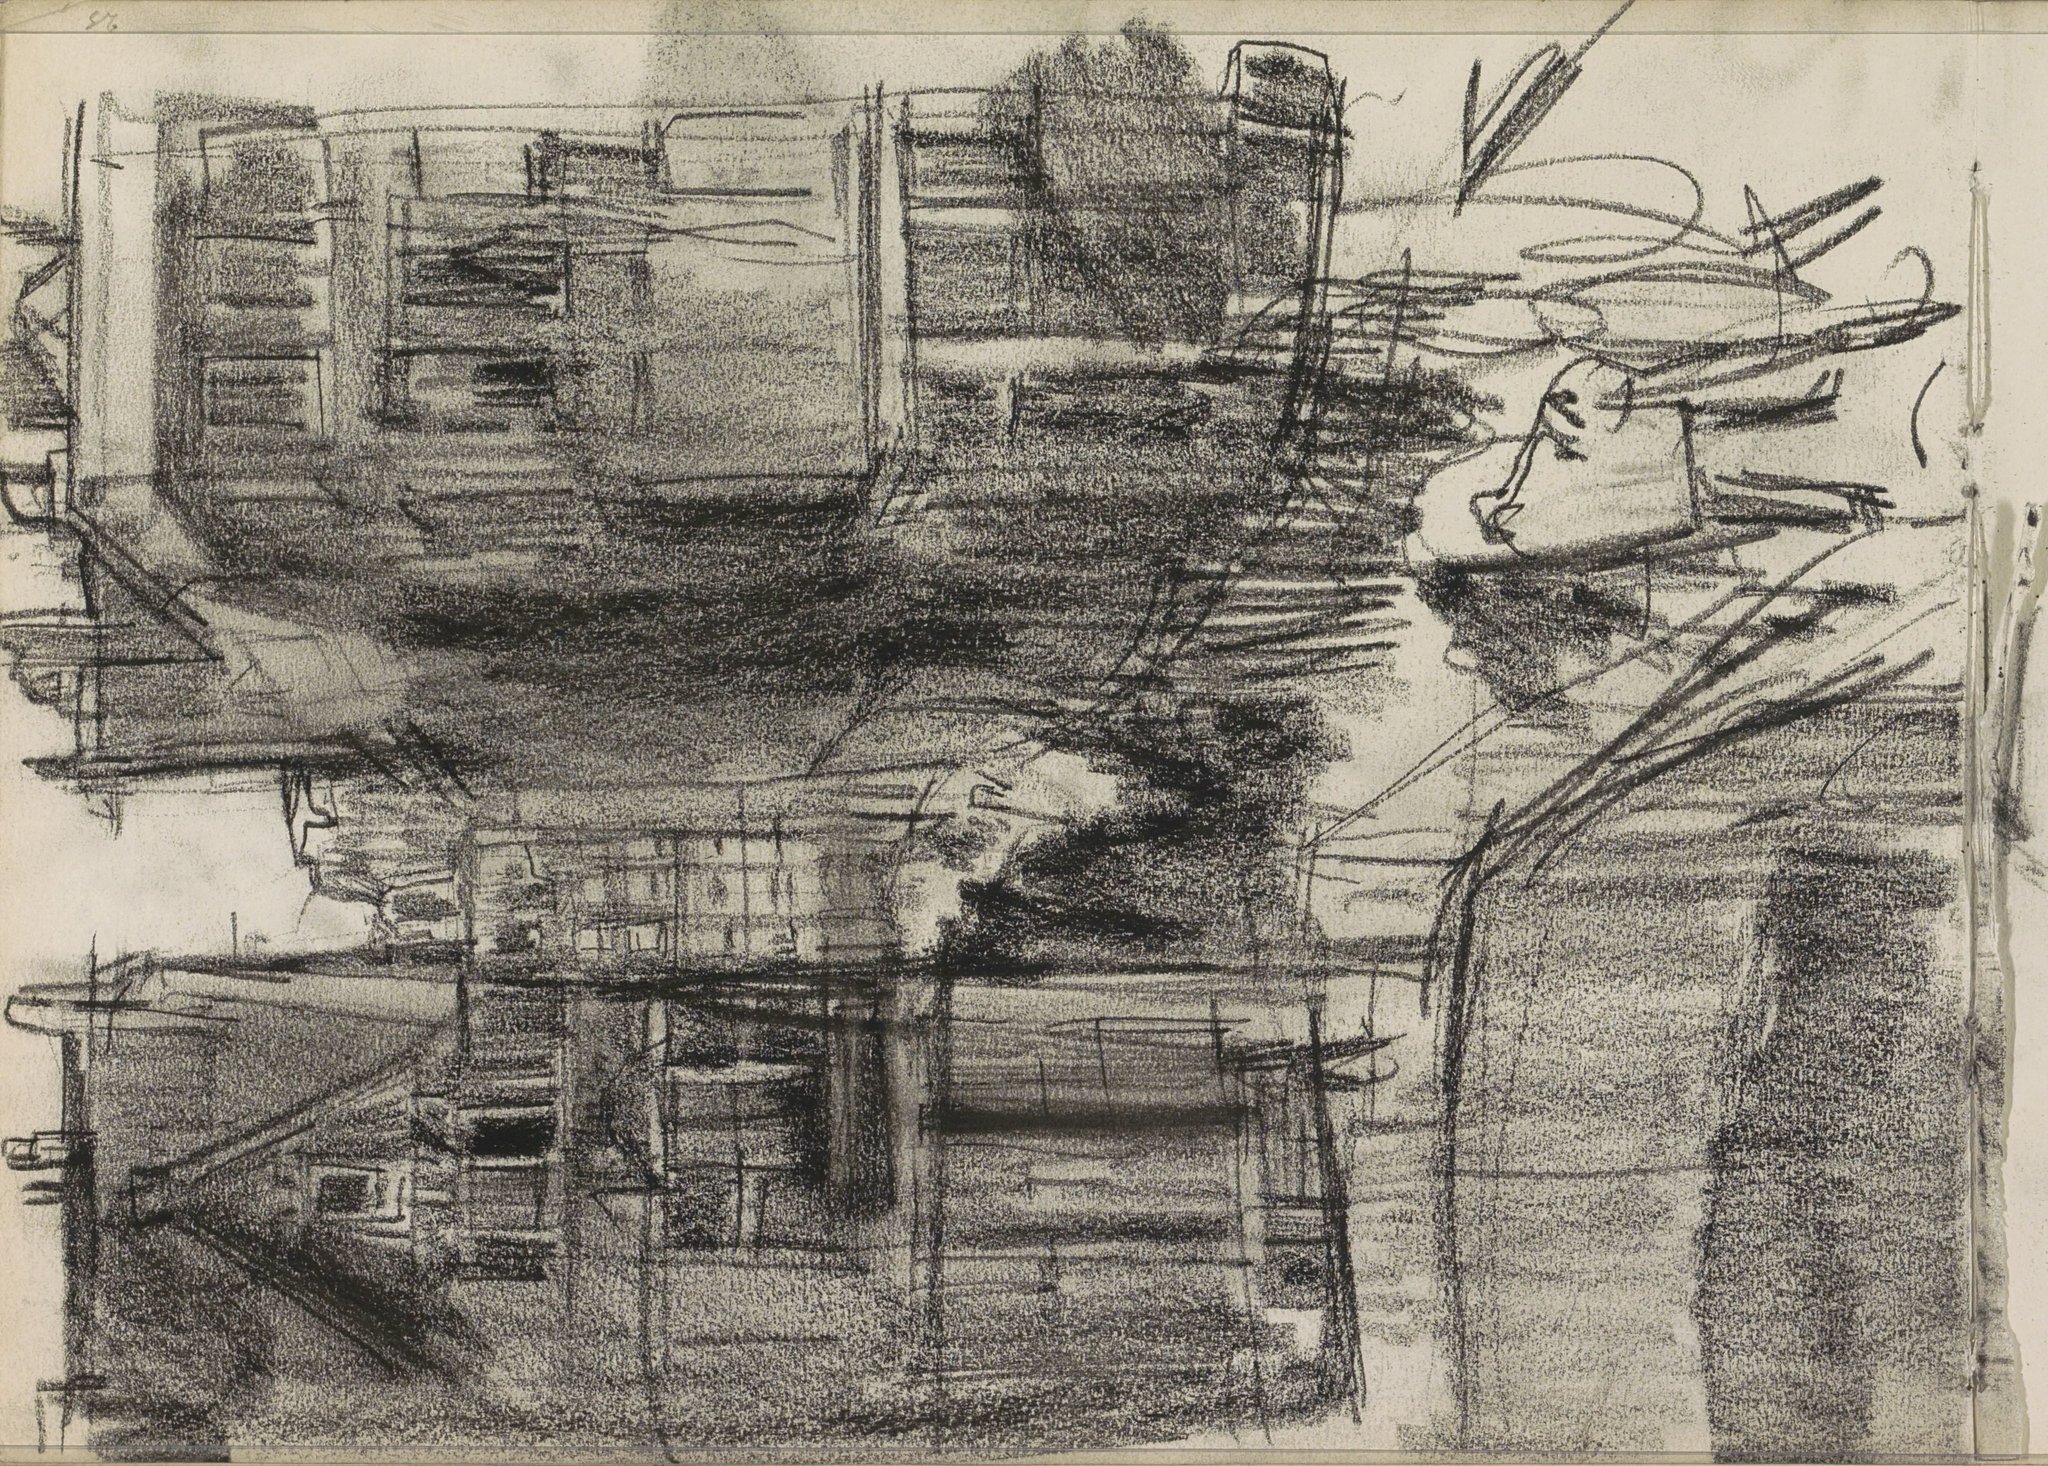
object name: sketchbook leaf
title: Gezicht op de Gasthuismolensteeg te Amsterdam, gezien vanuit Herengracht 232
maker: isaac israels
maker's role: draughtsman, painter, print maker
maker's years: 1865-1934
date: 1892-1900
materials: chalk, paper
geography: amsterdam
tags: urban housing, bridge in city across river, canal, etc.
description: Vooraan een brug die naar een steeg leidt. Blad 2 verso uit schetsboek VIII met 12 bladen.